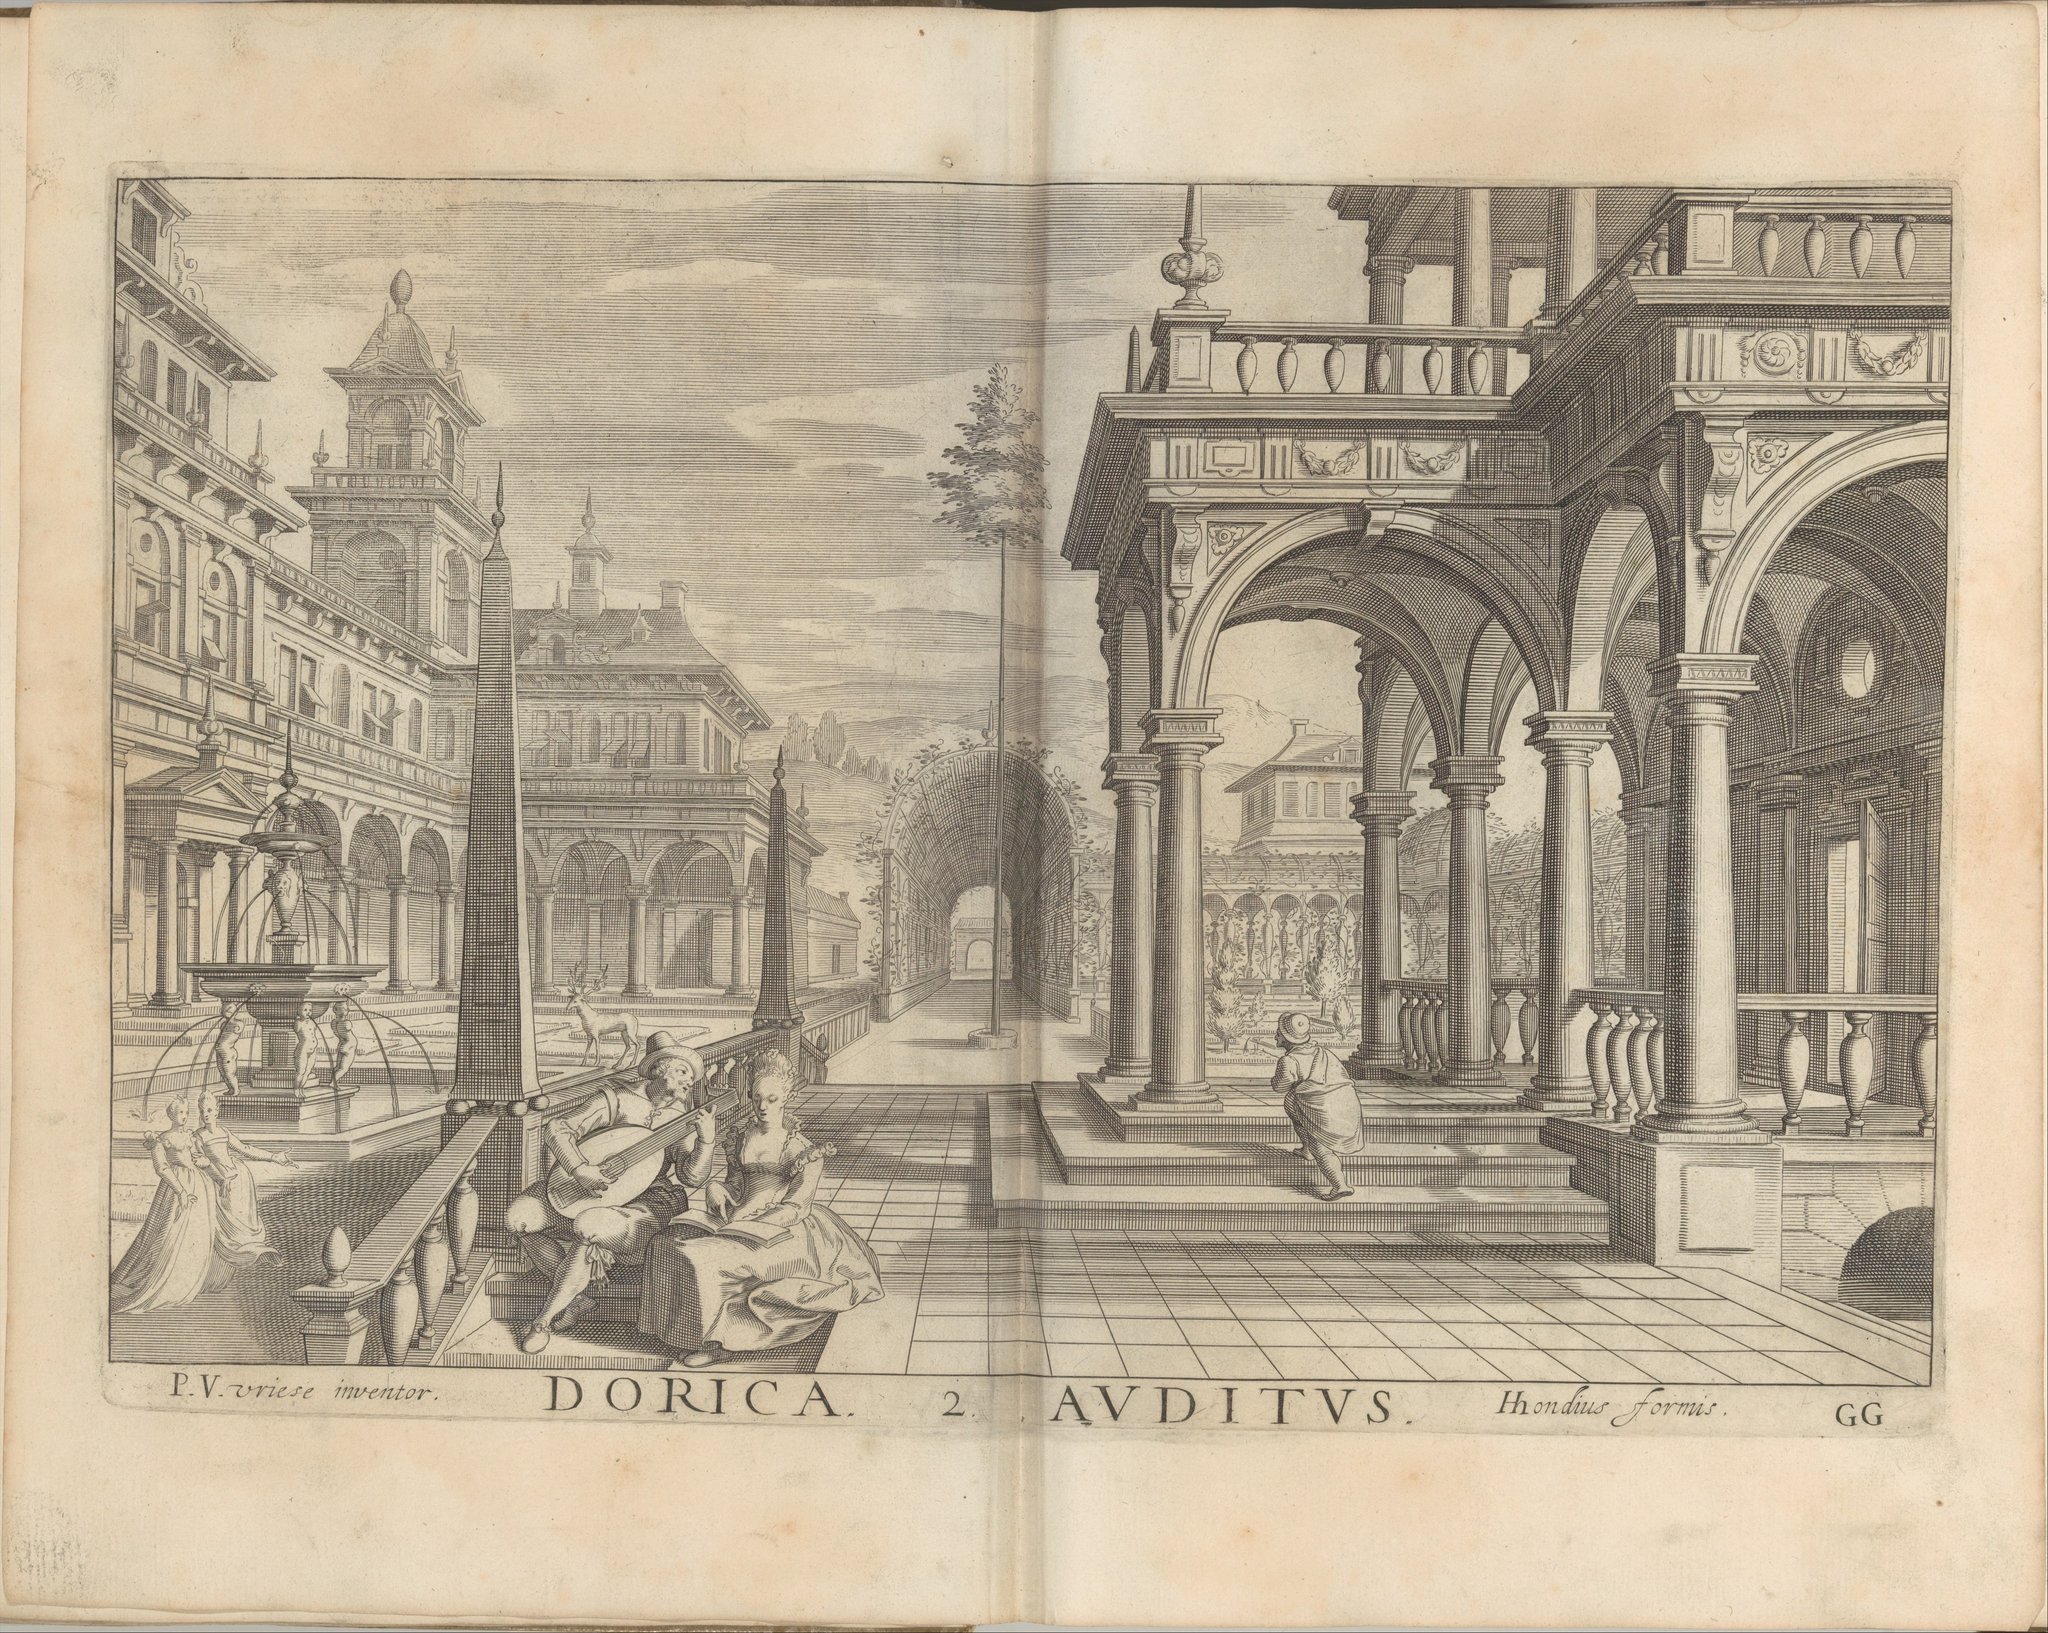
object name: book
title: Architectur oder Bawmeisterschaft...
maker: hans vredeman de vries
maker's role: artist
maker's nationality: netherlandish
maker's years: 1527-1606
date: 1628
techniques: engraving, etching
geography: amsterdam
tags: musical instruments,architecture,buildings,men,women